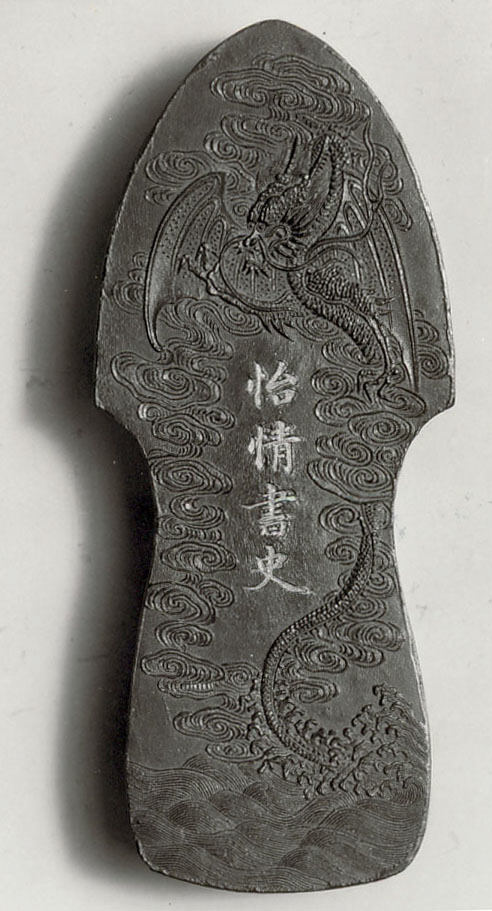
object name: ink tablet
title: Books and Histories that Delight One's Mind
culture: chinese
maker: jian guzhai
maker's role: artist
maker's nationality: chinese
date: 1867-1933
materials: ink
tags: dragons